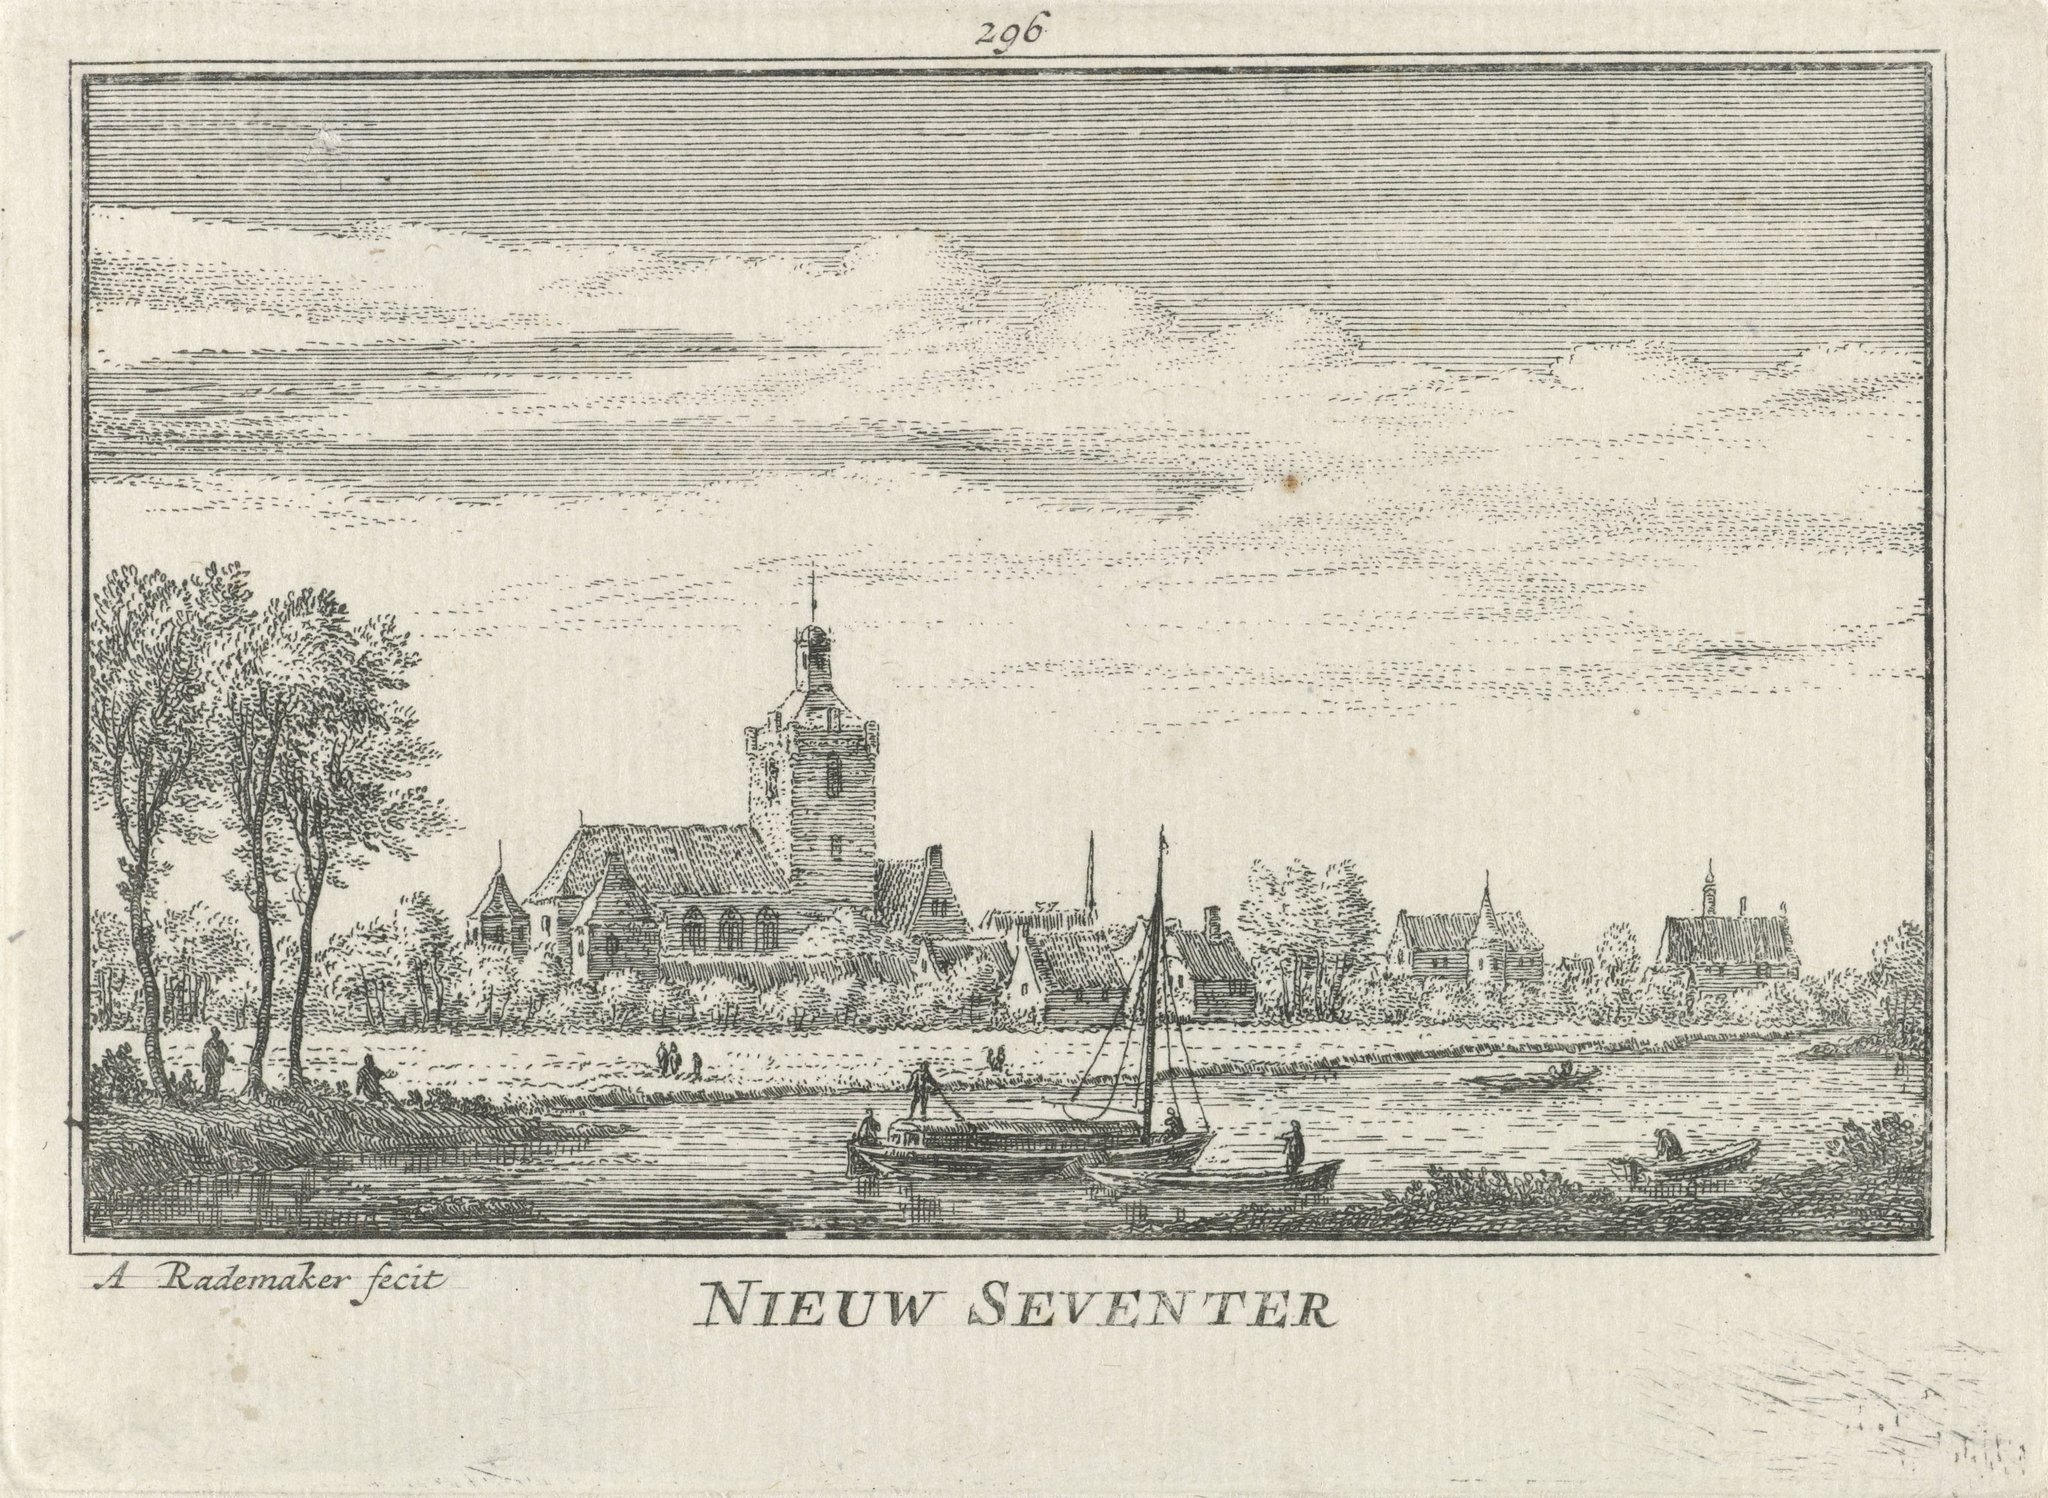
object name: print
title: Nieuw Seventer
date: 1727-1733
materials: paper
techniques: etching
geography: amsterdam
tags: sailing-ship, sailing-boat, church (exterior), rowing-boat, canoe, etc.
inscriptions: collector's mark: Lugt 2228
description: Illustratie uit: Abraham Rademaker, Matthaeus Brouërius van Niedek, Isaac Le Long, Kabinet van Nederlandsche en Kleefsche outheden en (...) voorname stads- en landgebouwen, Willem Barents en Antoni Schoonenburg: Amsterdam, 1727-1733, ill. nr. 296.